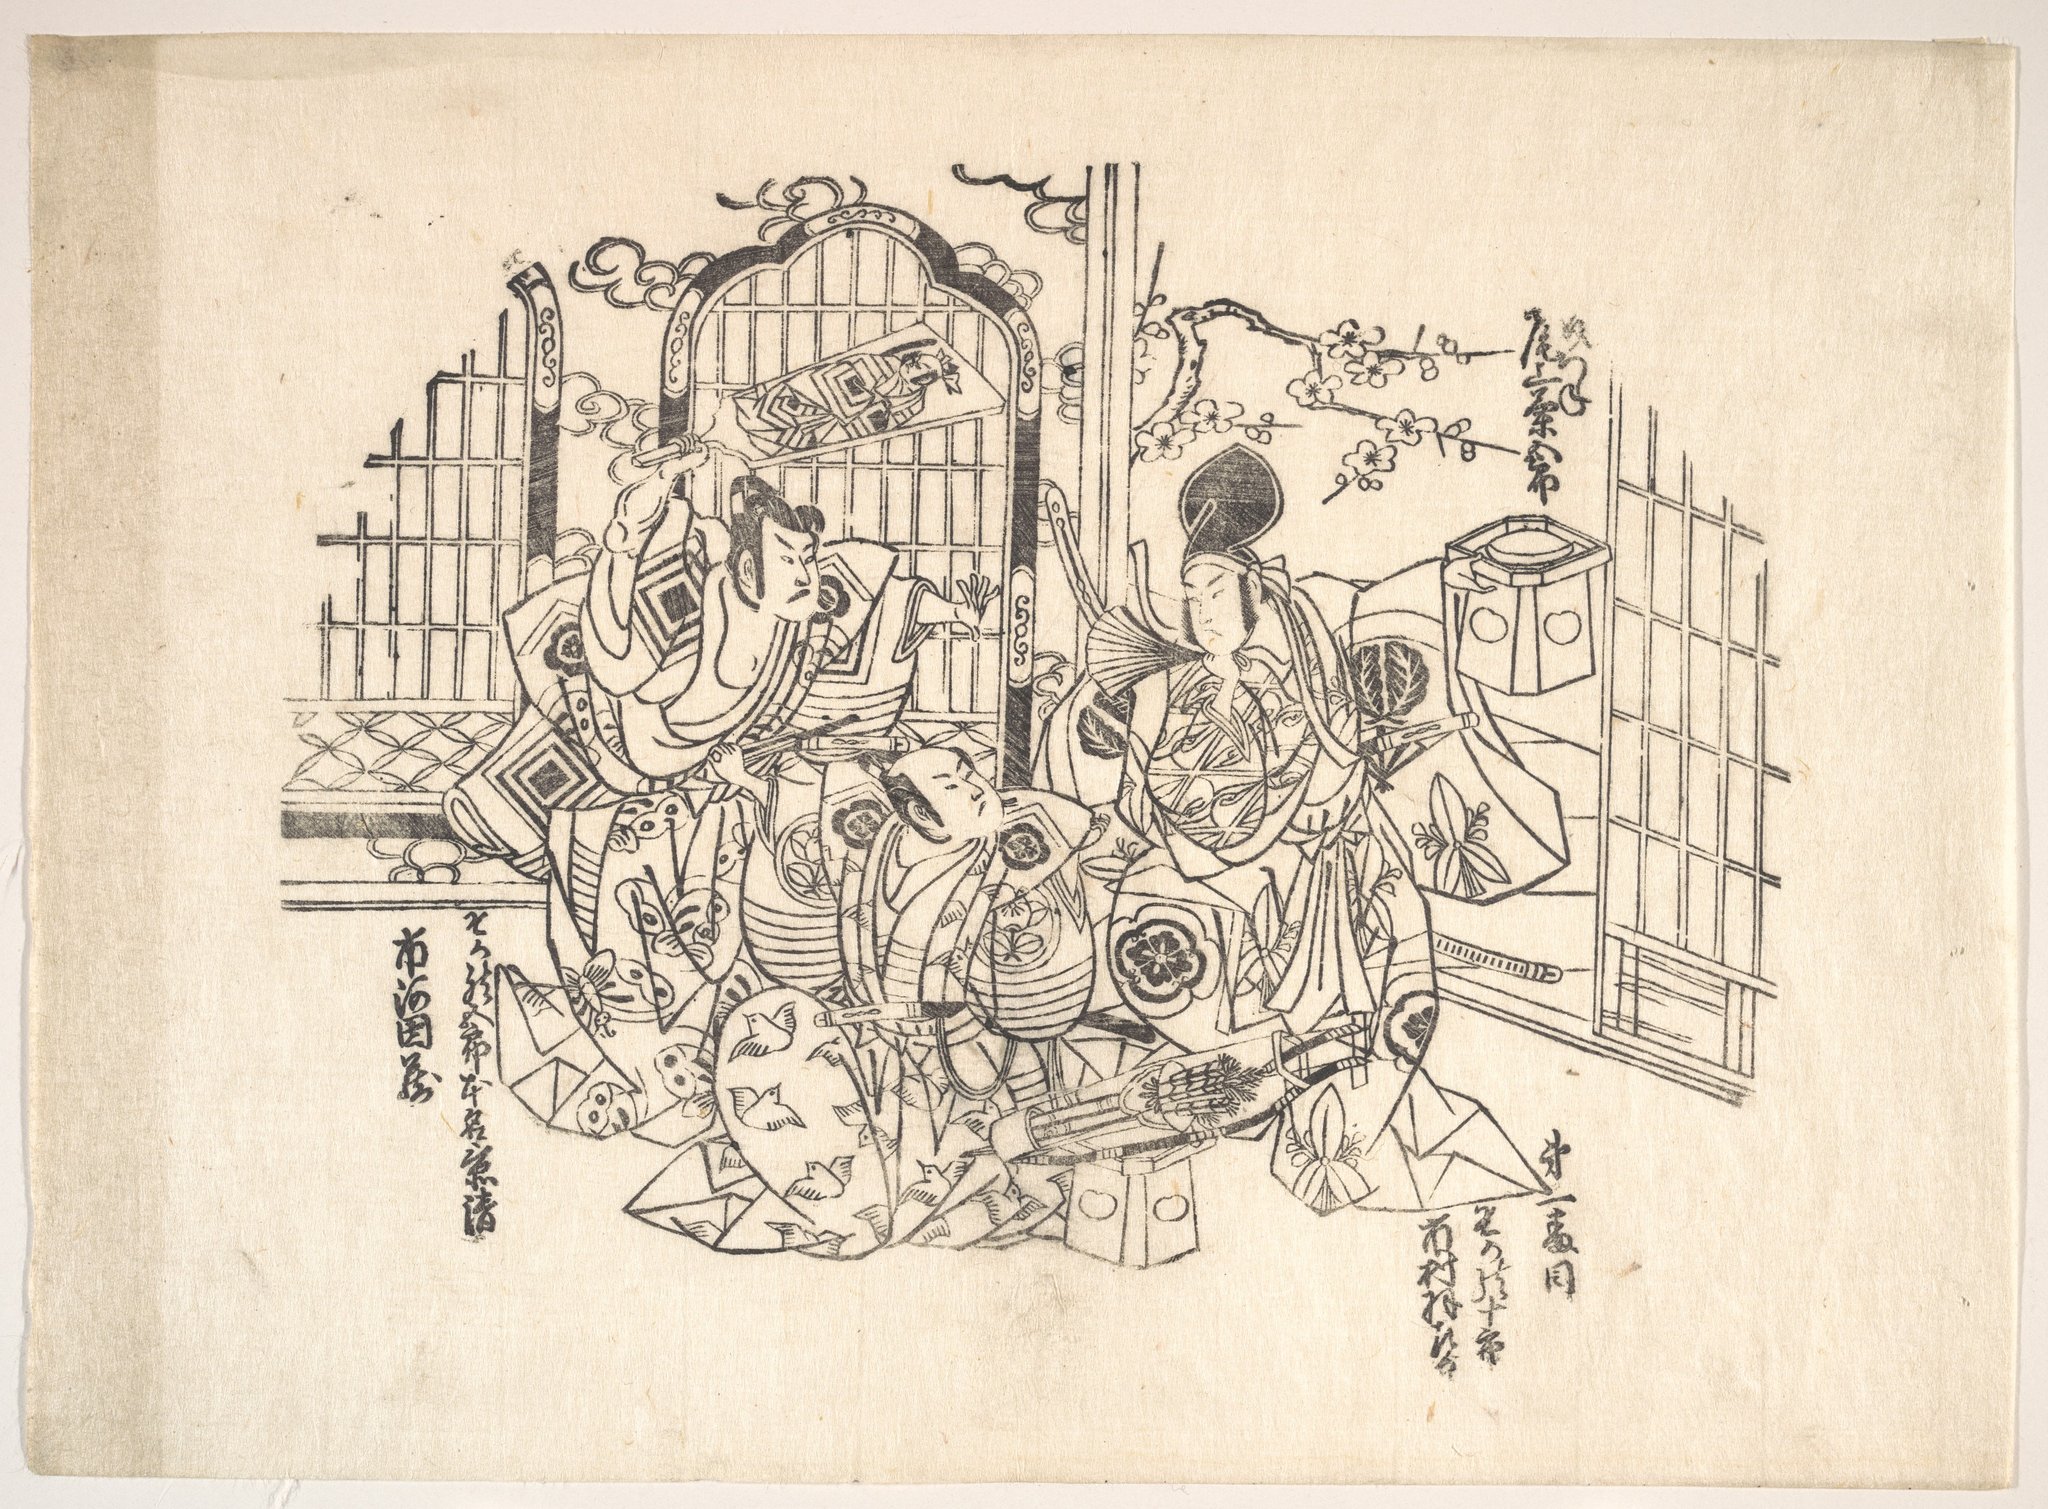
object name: print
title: One of Six Impressions from Worn Old Blocks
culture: japanese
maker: unidentified artist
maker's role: artist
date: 1700-1799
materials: ink, paper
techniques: woodblock print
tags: men